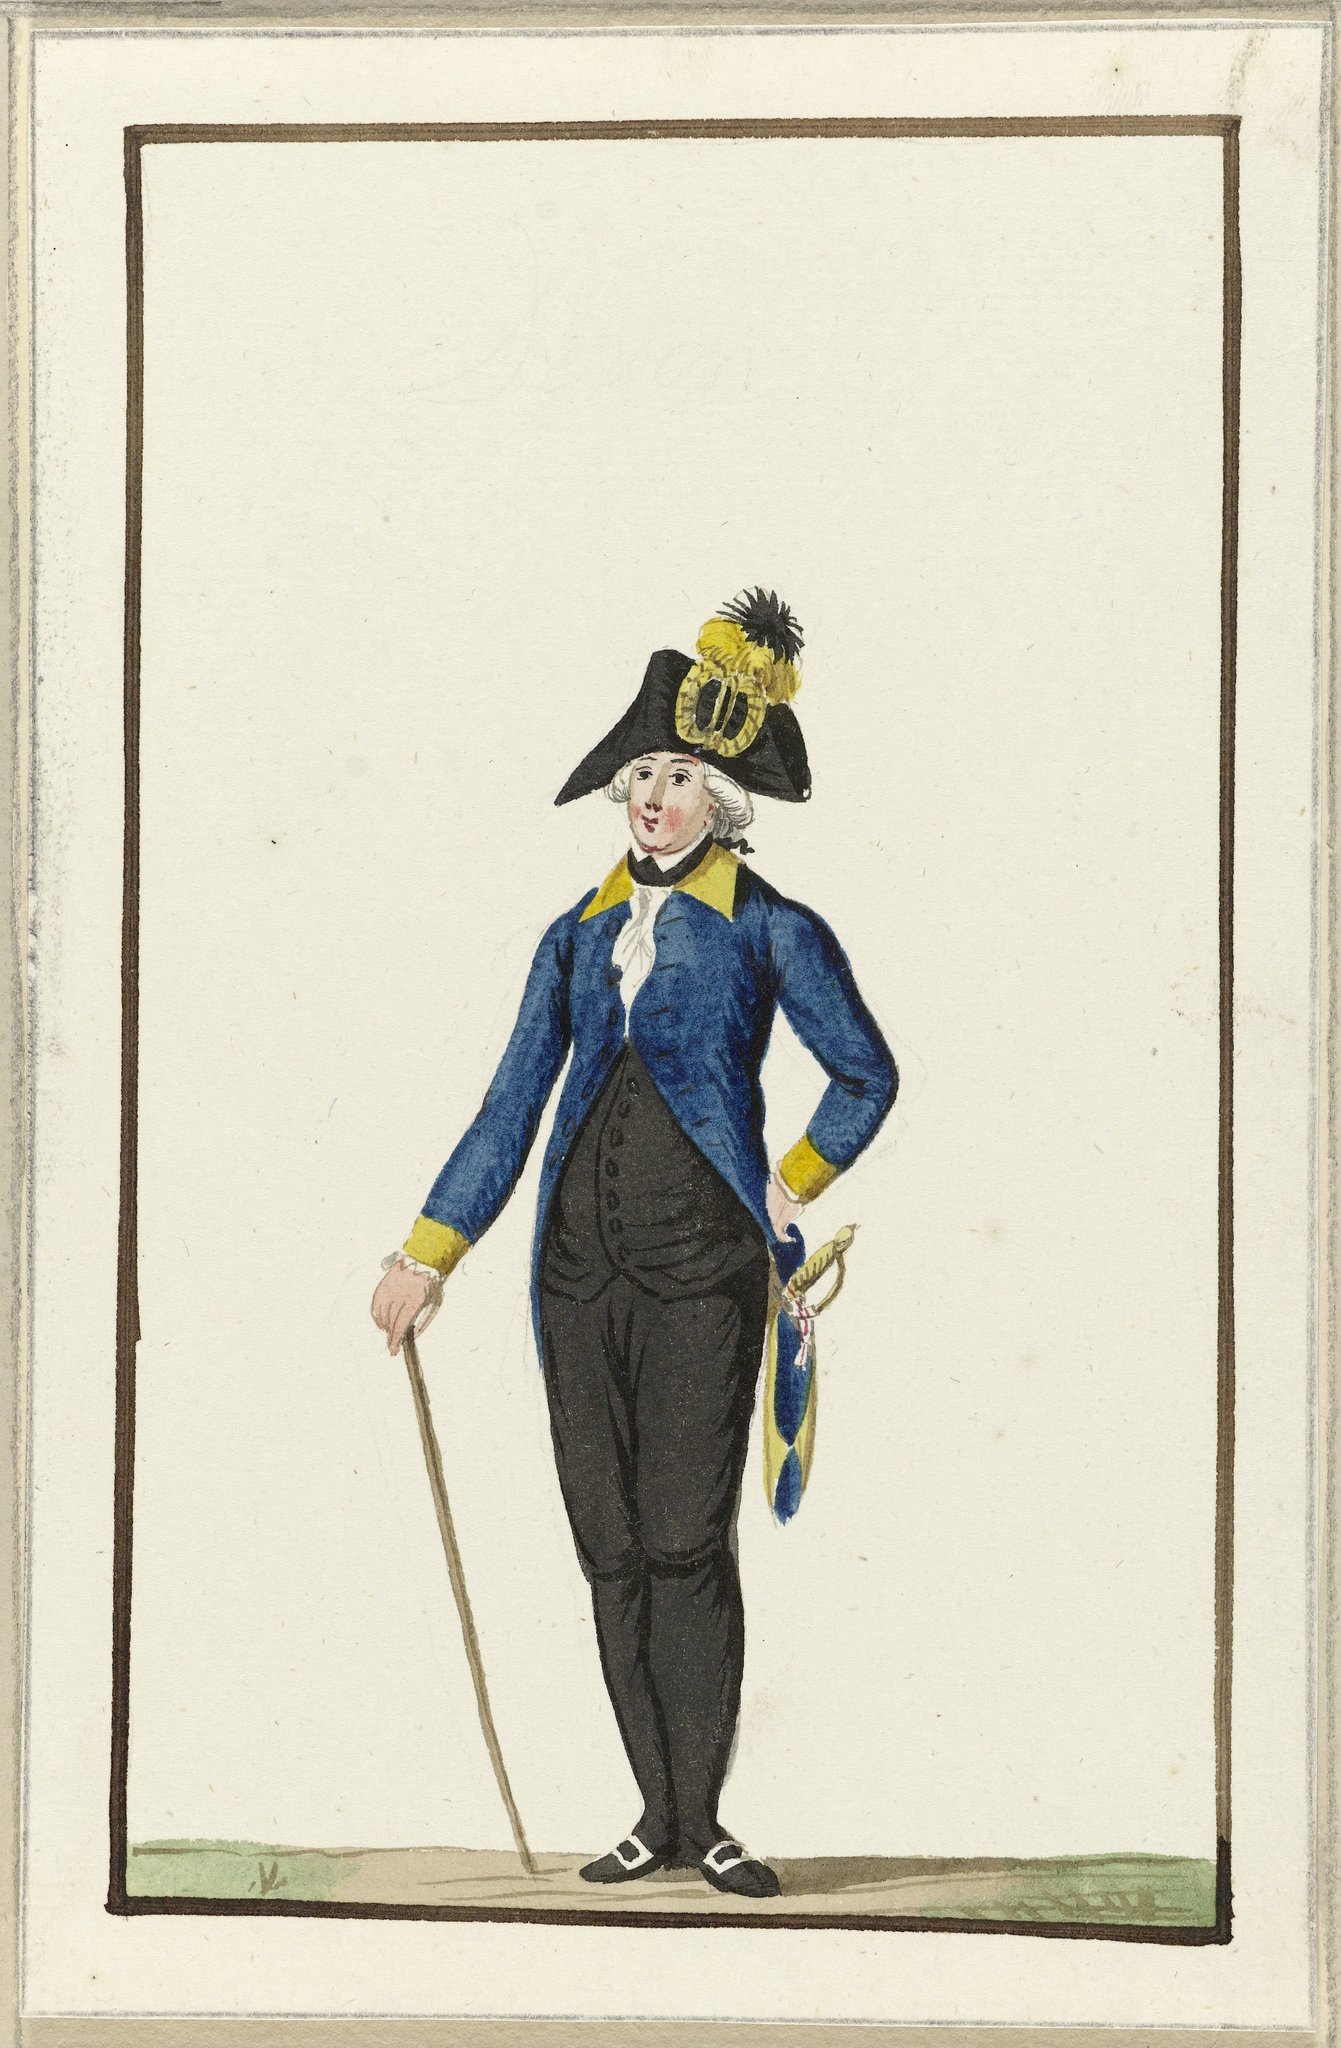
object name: costume print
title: Monteringen van 32 patriotse schutterijen en vrijkorpsen, ca. 1787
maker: Anonymous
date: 1787-1790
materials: paper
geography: northern netherlands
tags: (military) uniforms (+ citizen soldiery, civil guard, citizen militia), deventer, patriots (1780-1795)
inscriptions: collector's mark: Lugt 2228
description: Uniform van de schutterij van Deventer. Onderdeel van een serie van 32 tekeningen van de verschillende monteringen (uniformen) van patriotse schutterijen en burgerkorpsen in Nederland in 1787.